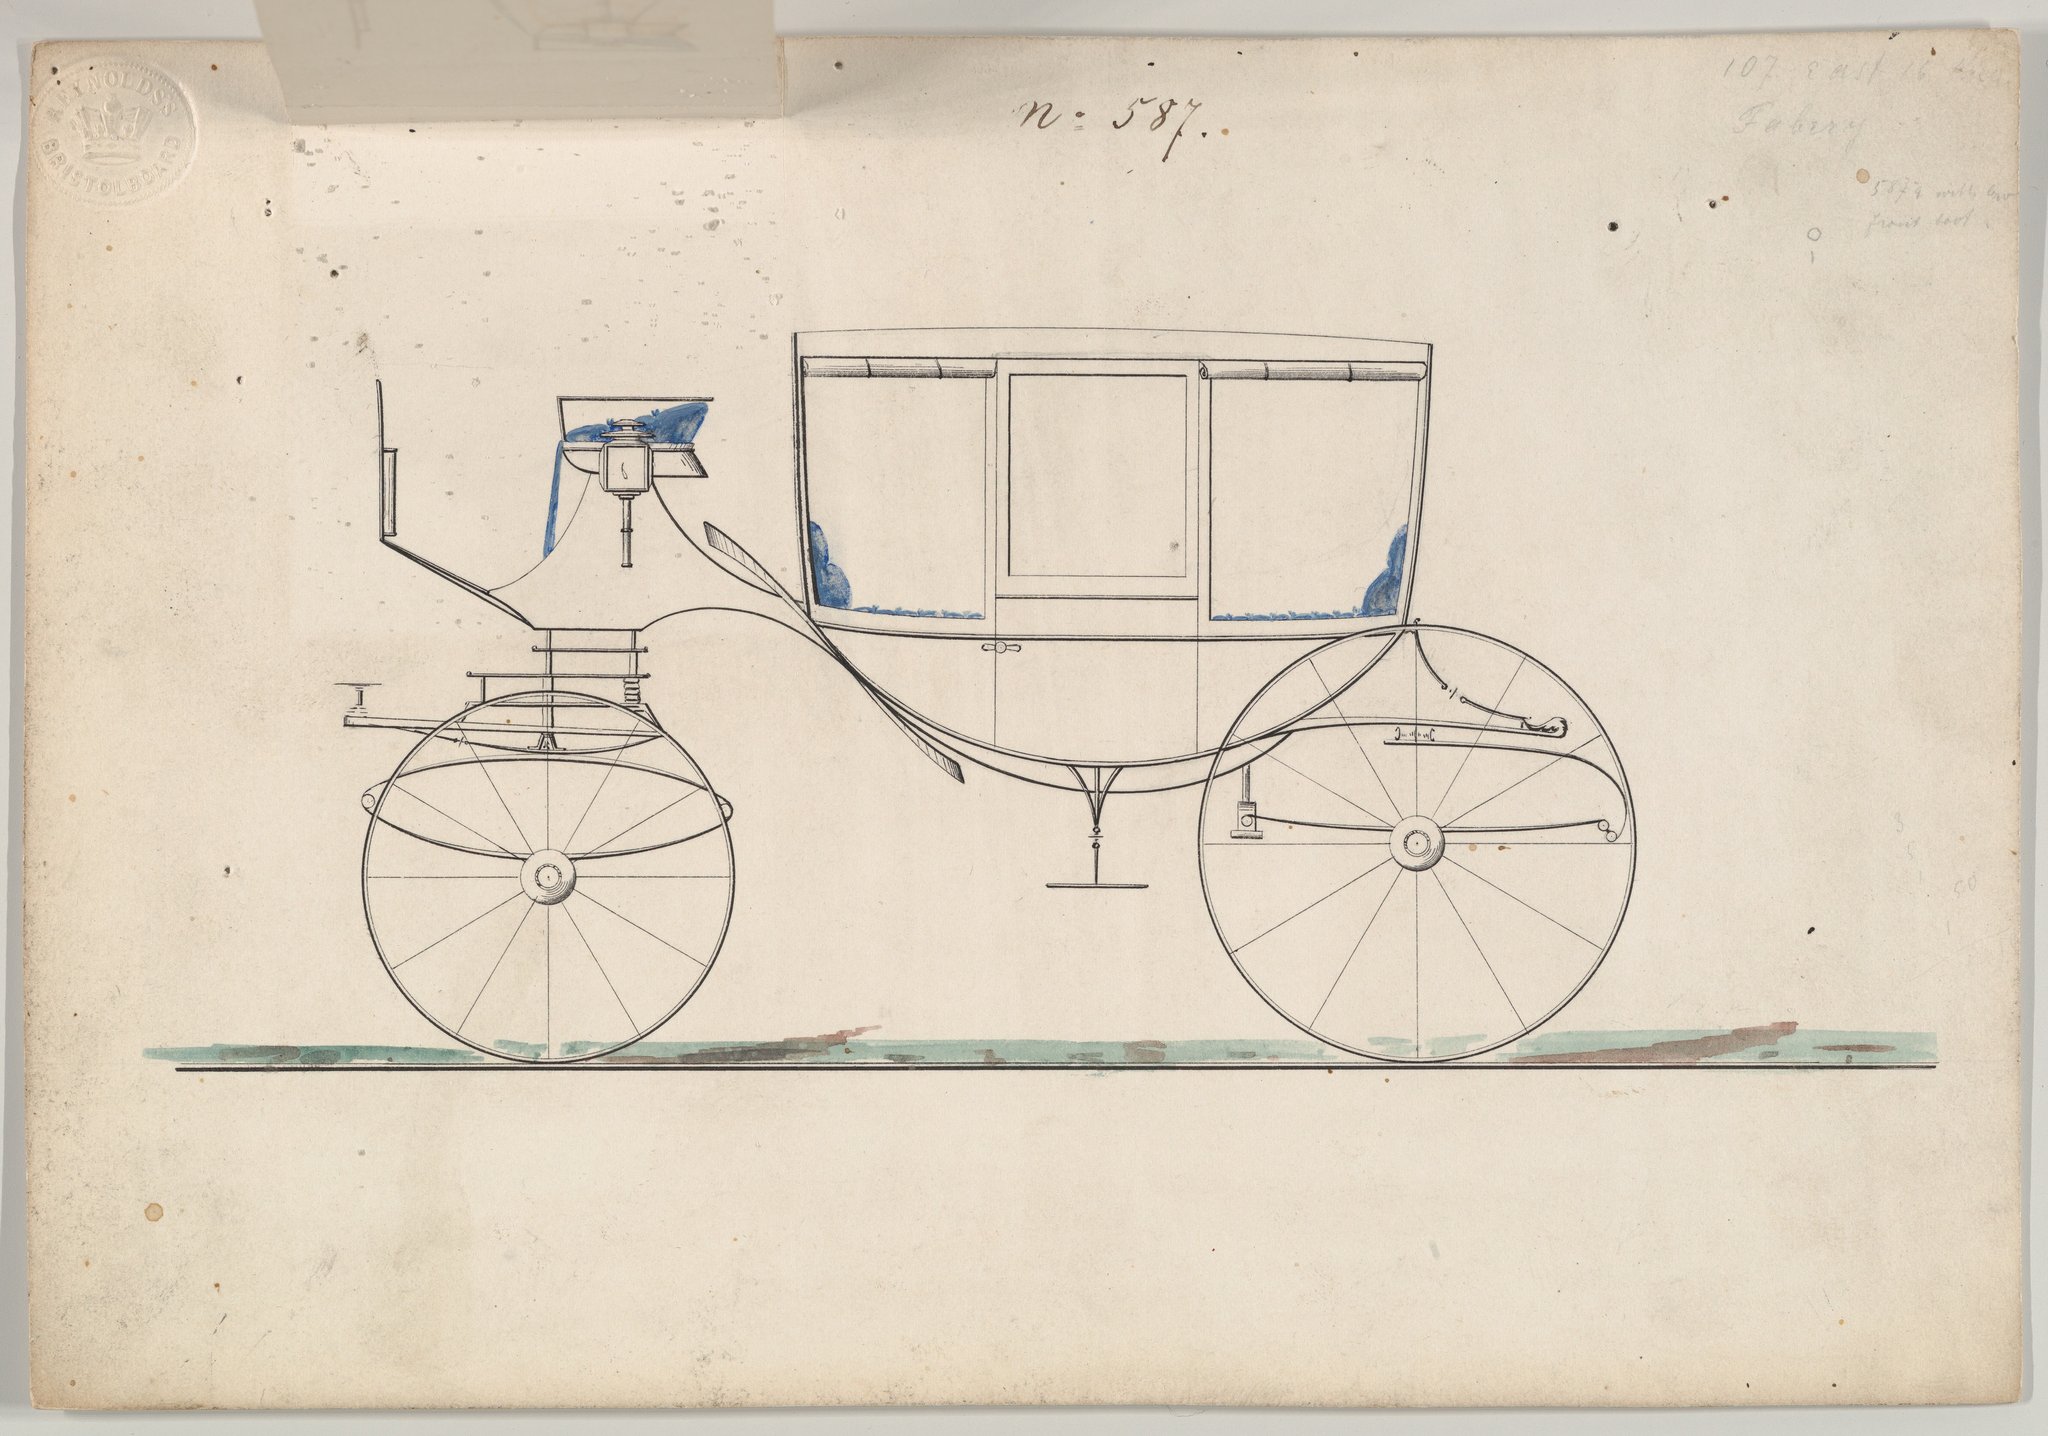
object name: drawing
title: Curtain Coach #587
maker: brewster & co.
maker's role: manufacturer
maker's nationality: american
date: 1870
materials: graphite, ink, watercolor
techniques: pen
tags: carriages